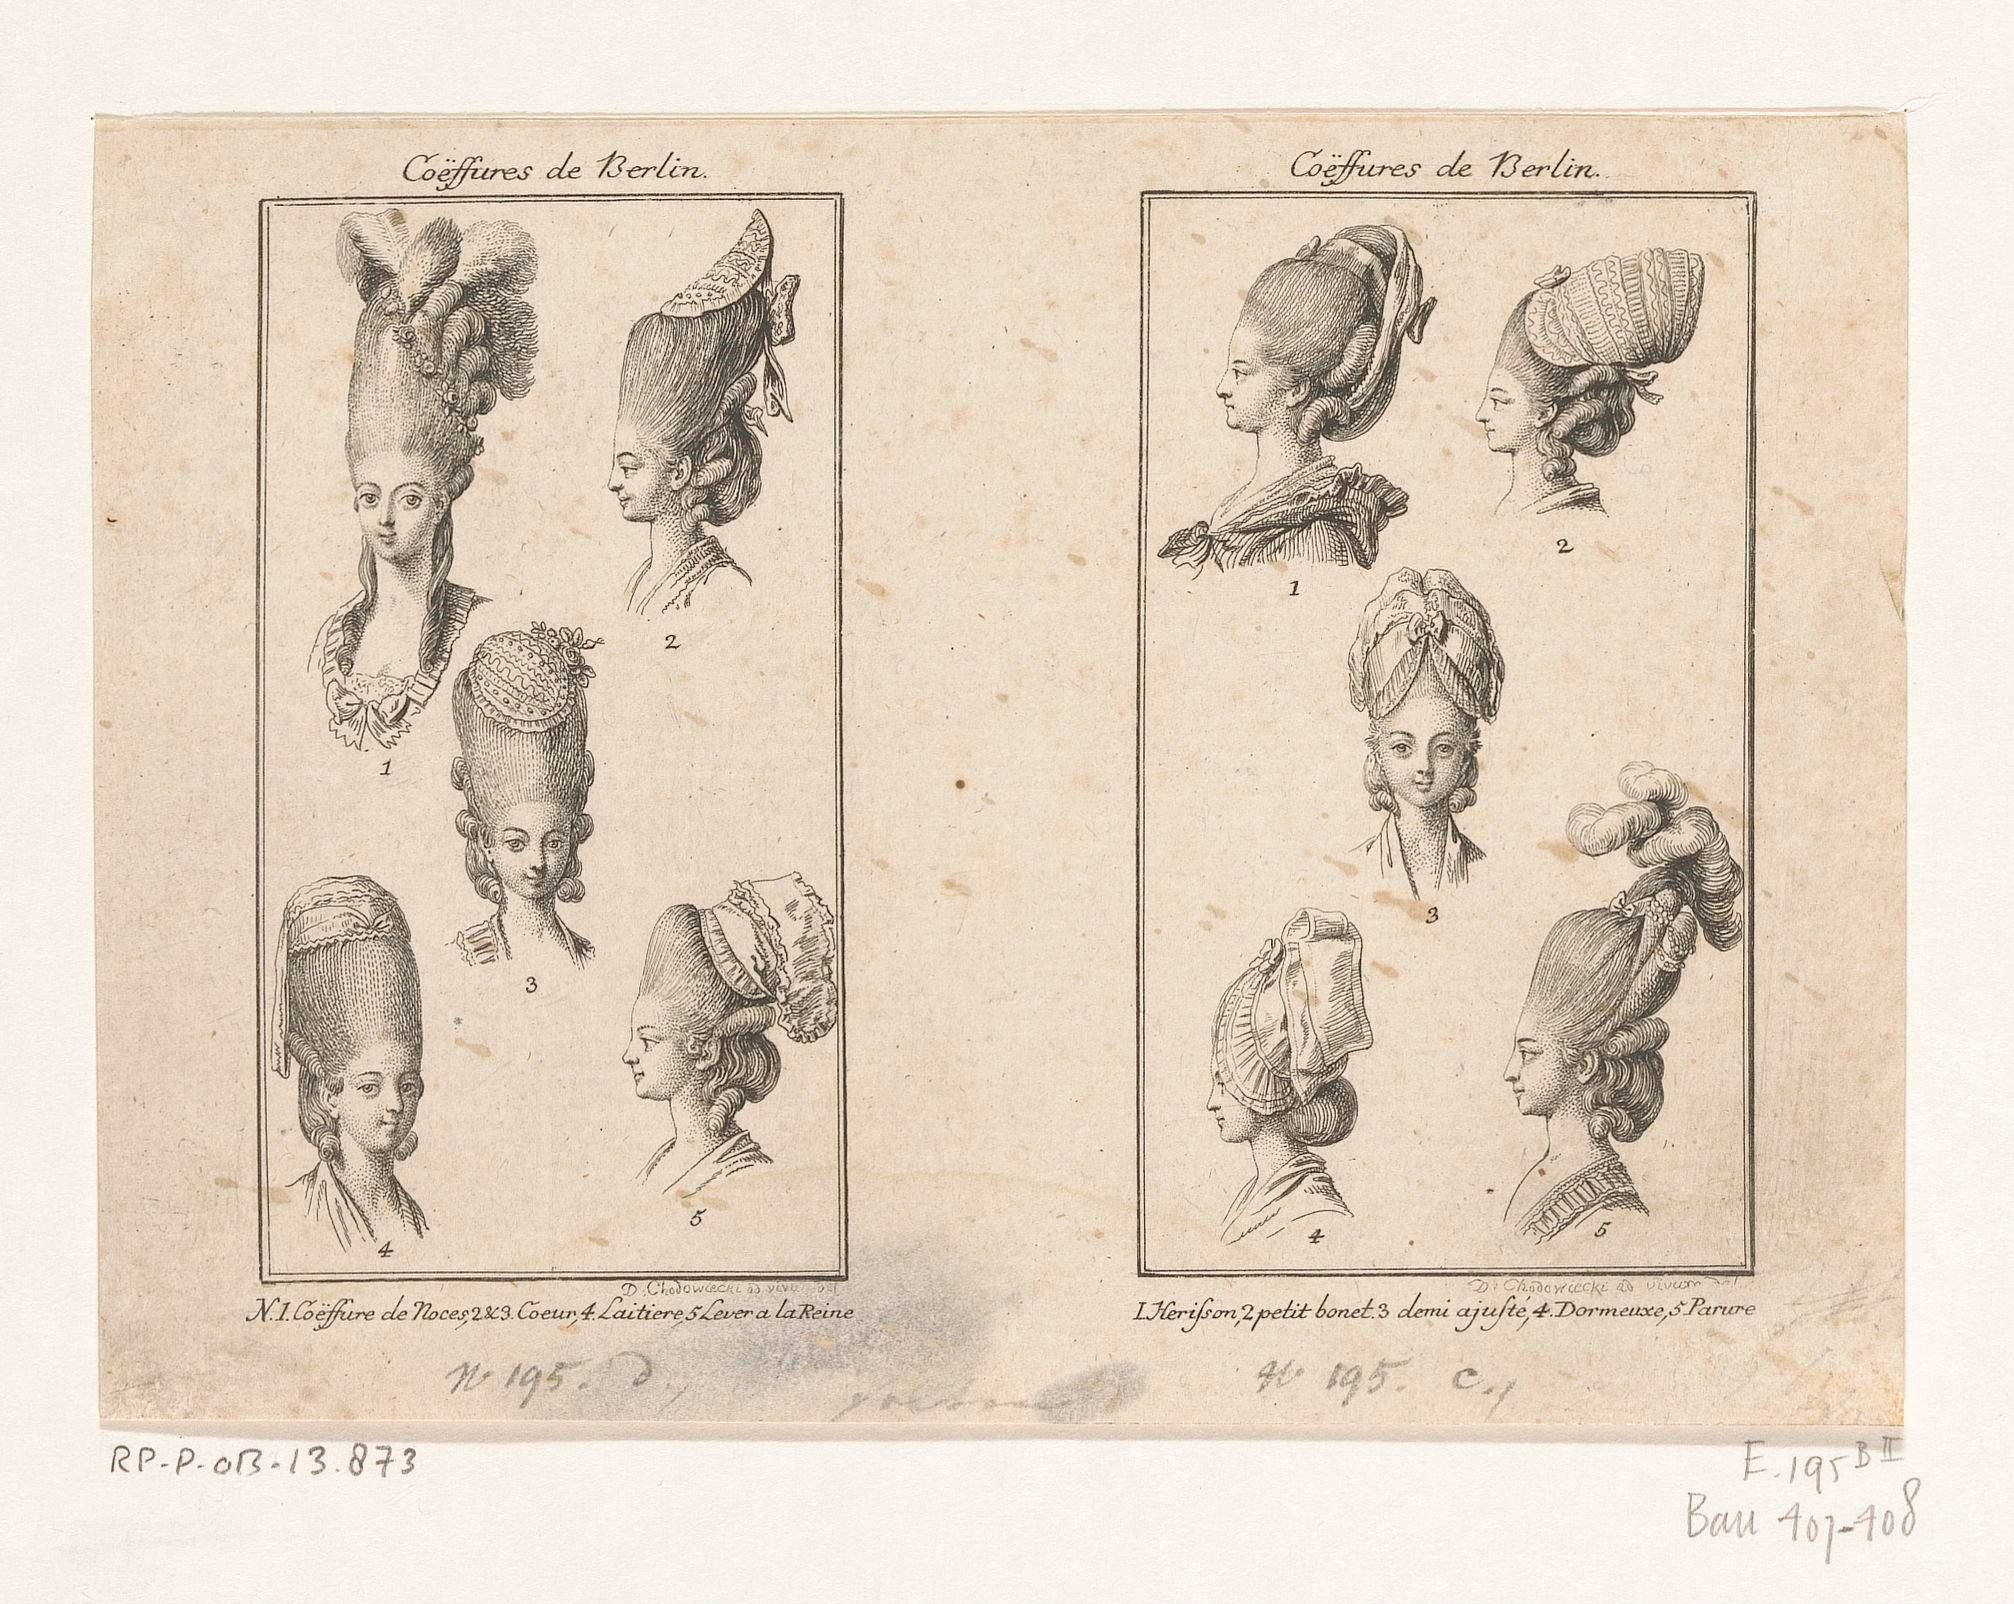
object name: print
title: Coëffures de Berlin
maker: daniel nikolaus chodowiecki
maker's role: draughtsman, print maker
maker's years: 1726-1801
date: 1777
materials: paper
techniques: etching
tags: head-gear (+ women's clothes), styles of hairdress - aa - ~ women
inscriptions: collector's mark: Lugt 2228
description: Ook gebruikt in: Voss, Johann Heinrich. Musen Almanach für 1778. Hamburg: L.E. Bohn.